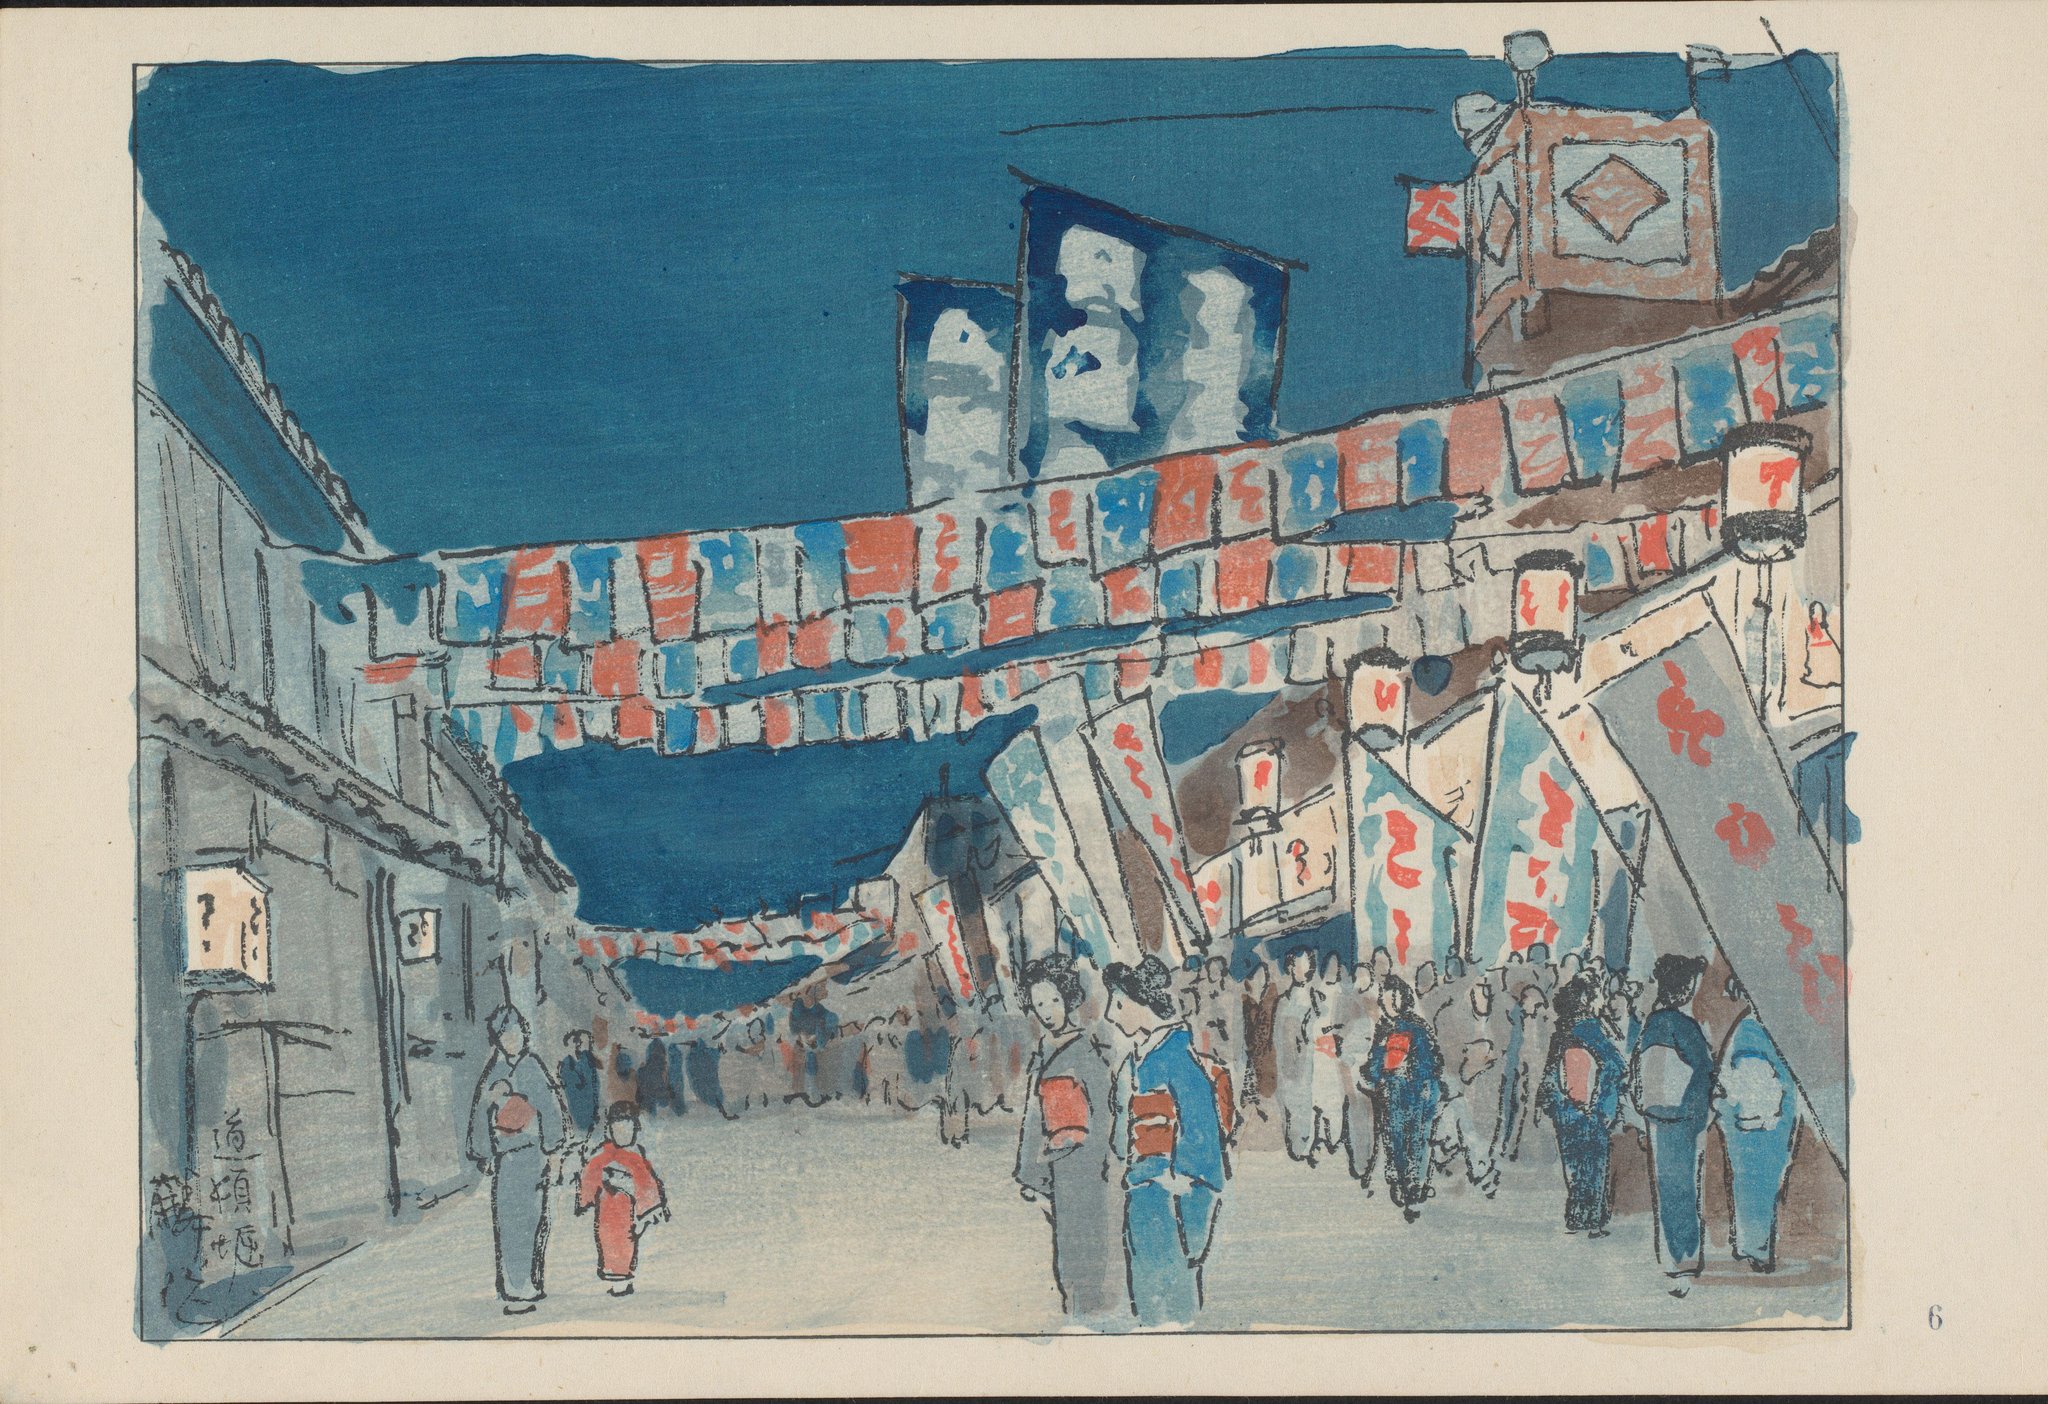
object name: print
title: Dotombori, theater street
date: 1947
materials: paper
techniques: woodcut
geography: japan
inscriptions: date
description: De drukke straat Dôtonbori, met verschillende stalletjes langs de weg.